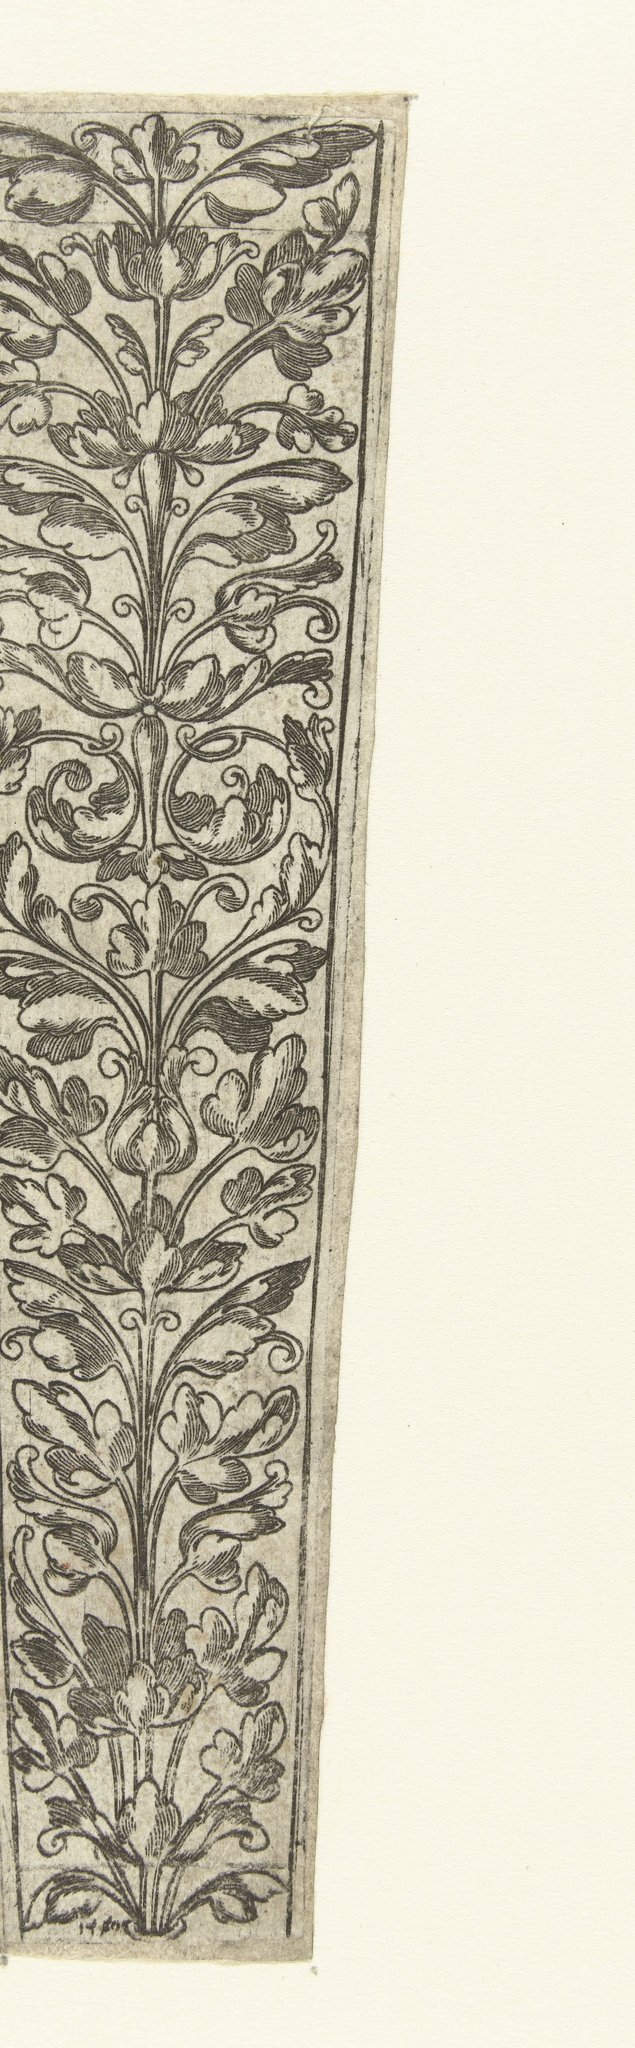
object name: print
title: Heft van een mes, gedecoreerd met bladranken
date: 1500-1600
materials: paper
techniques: engraving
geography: germany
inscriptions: collector's mark: Lugt 240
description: De decoratie bestaat uit een kaarsrechte middenstengel met kleine zijscheuten.